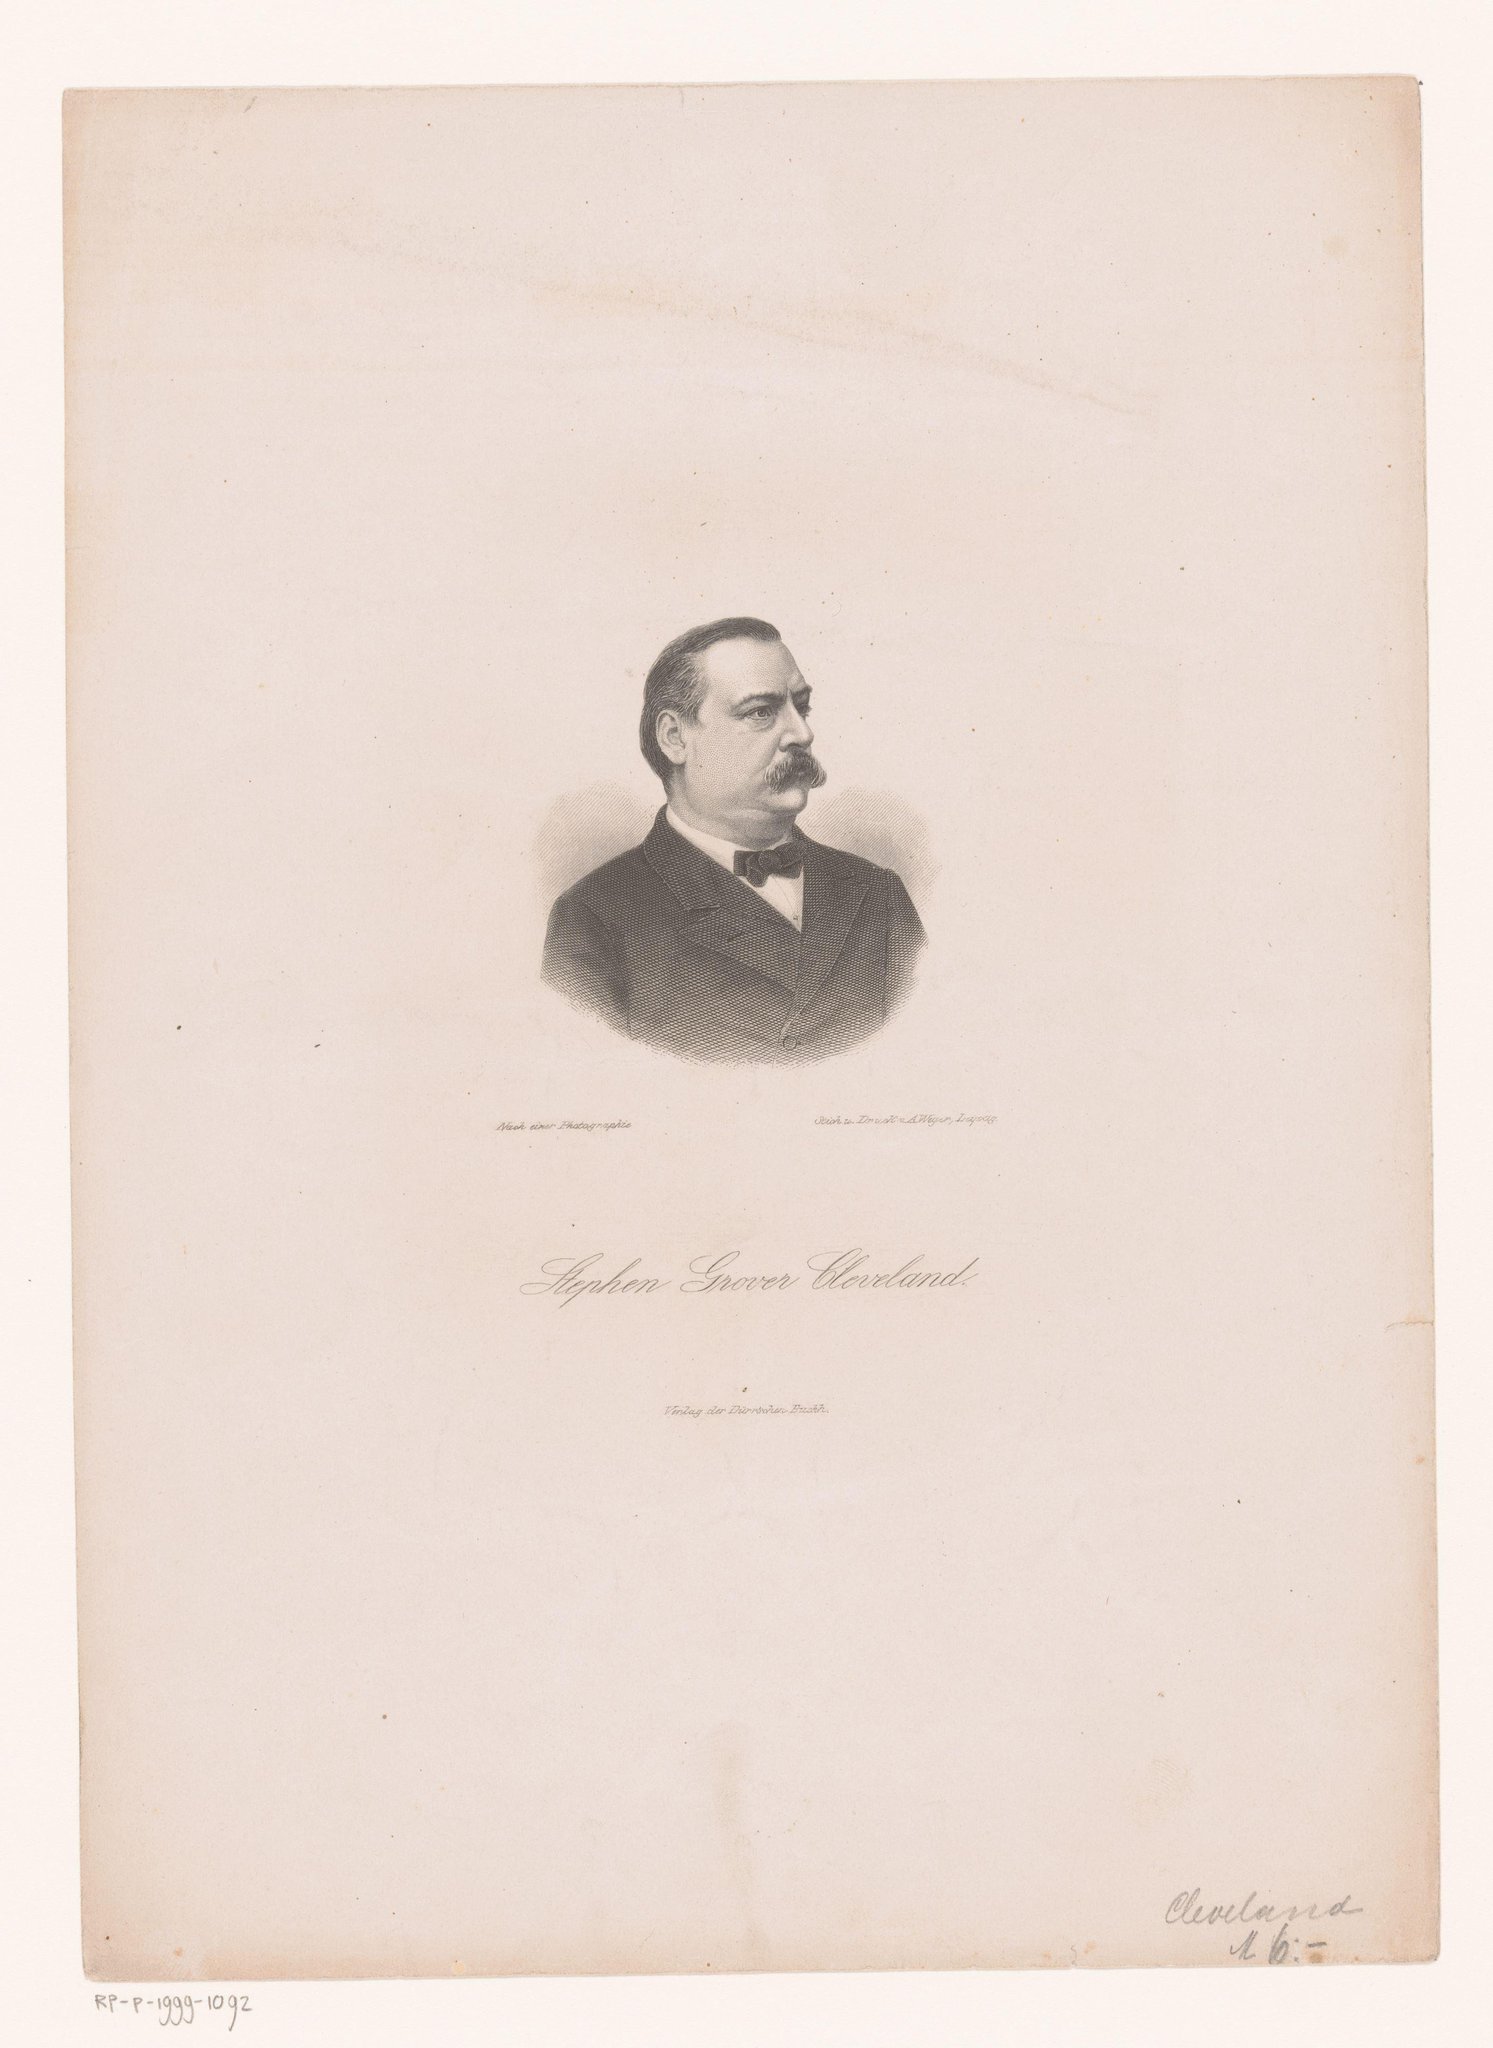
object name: print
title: Portret van Grover Cleveland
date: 1870-1892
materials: paper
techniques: engraving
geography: leipzig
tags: politician, historical persons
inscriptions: collector's mark: Lugt 2228, collector's mark: Lugt 2760, collector's mark: ‘Franz Radestock’